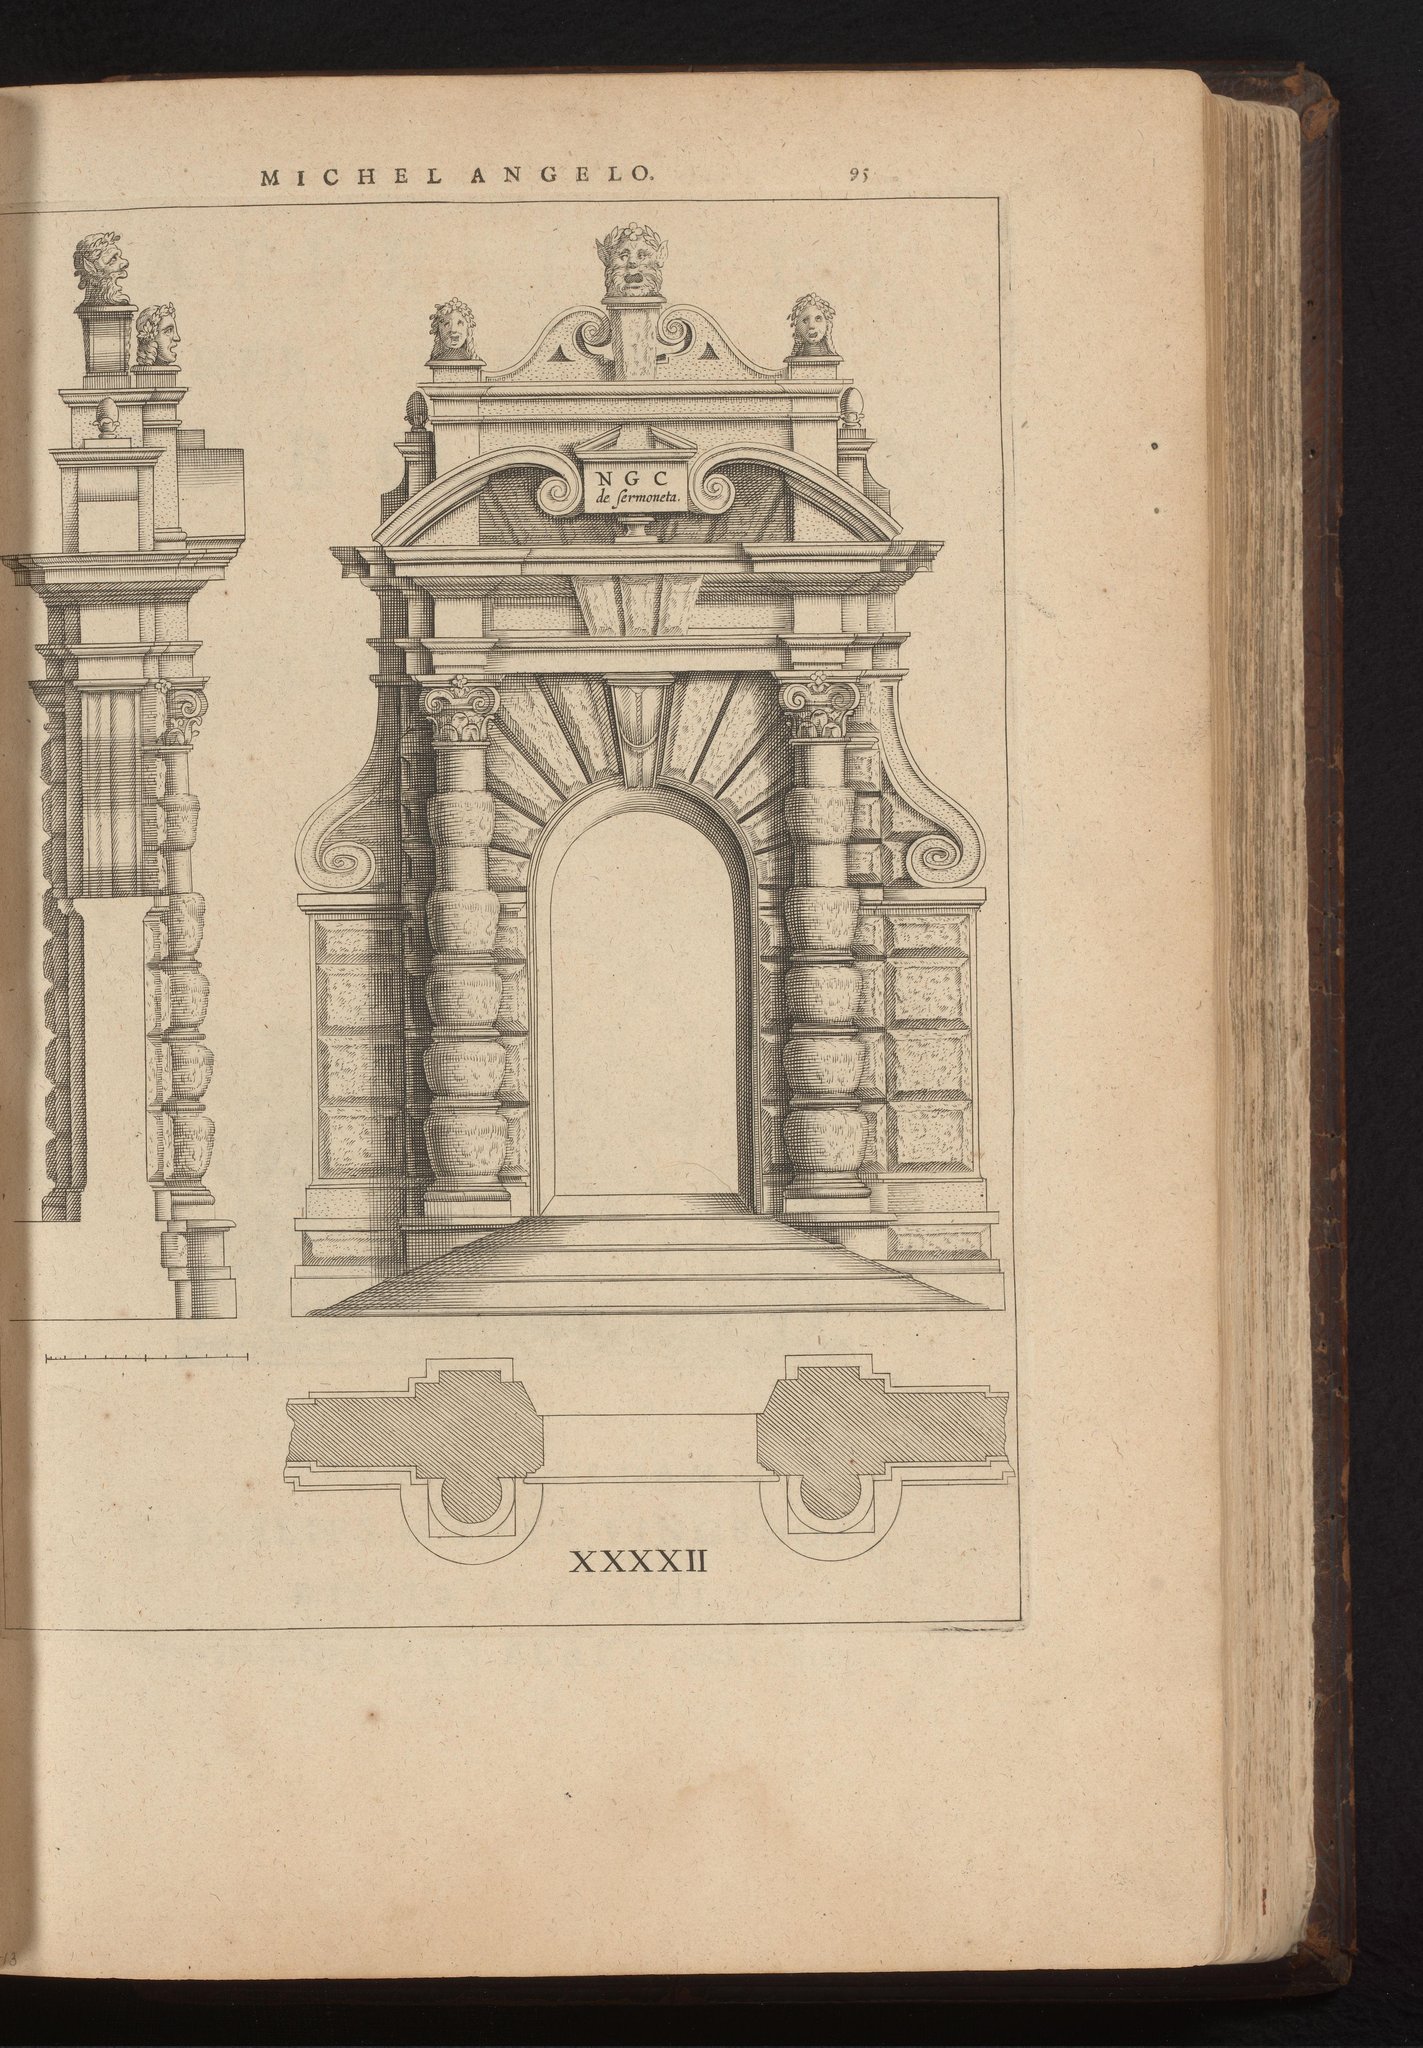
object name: book illustration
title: Poort van de tuin van kardinaal Niccolò Caetani di Sermoneta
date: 1640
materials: paper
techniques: engraving, letterpress printing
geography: amsterdam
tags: gate, entrance, architecture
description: Prent uit: Vignola, Giacomo Barozzi da. Regola delli cinque ordini d'architettura (...). Amsterdam: Johannes Willemszoon en Cornelis Blaeu, 1640, p. 95.